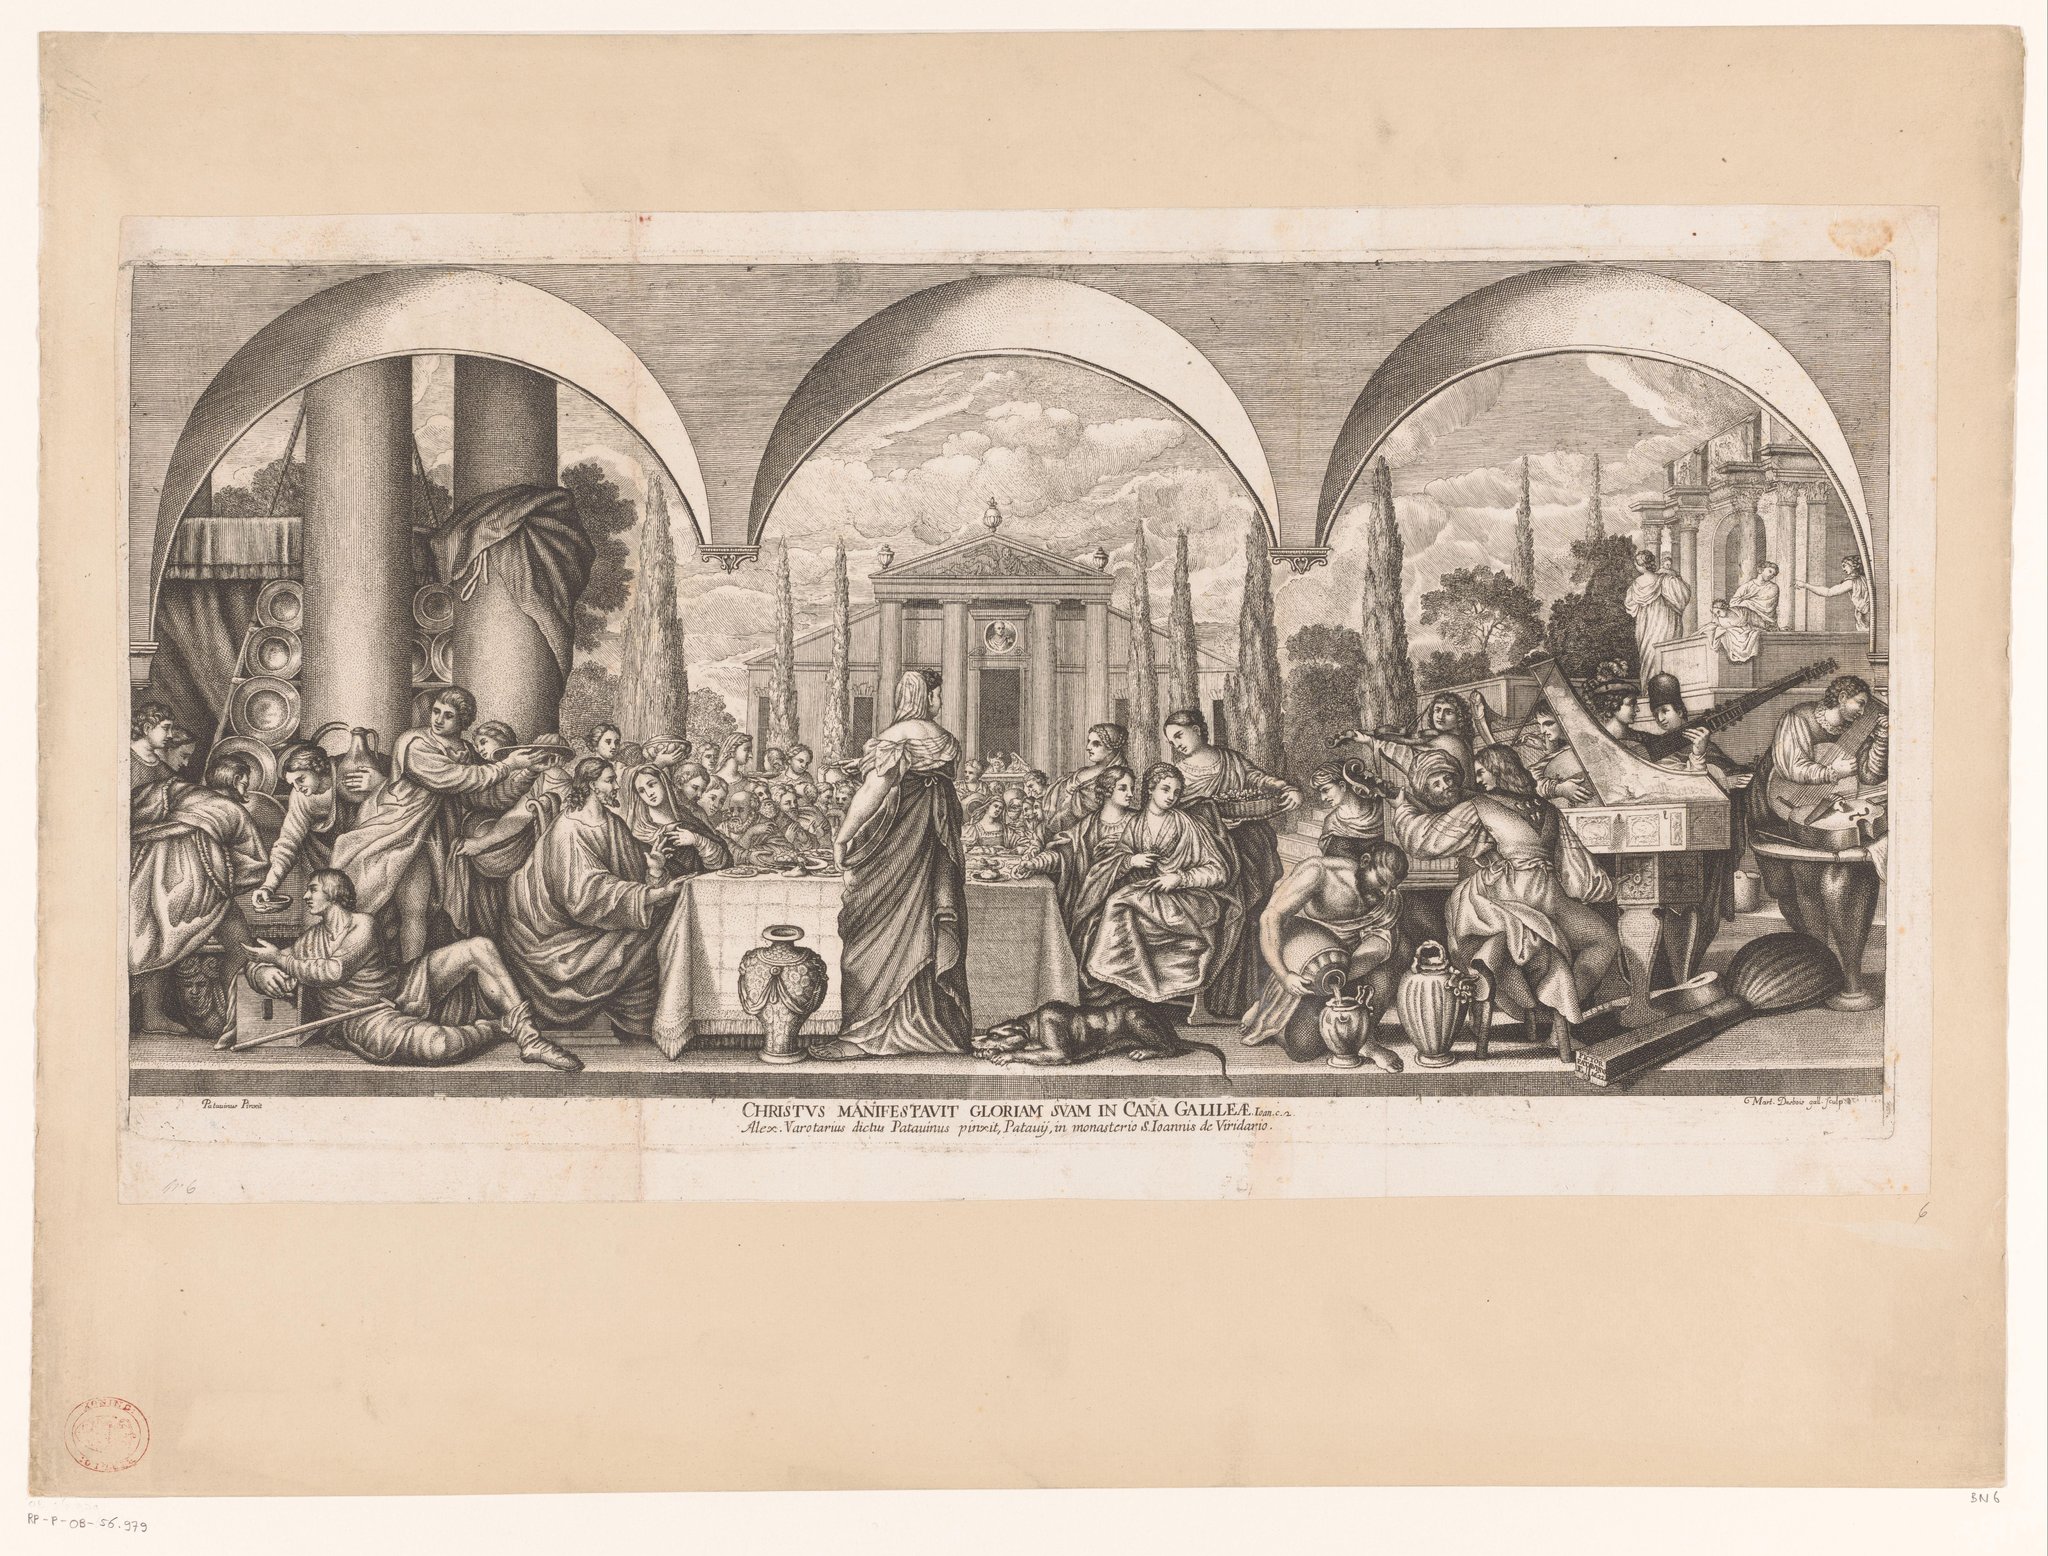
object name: book illustration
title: Christus Manifestavit Gloriam Suam in Cana Galileae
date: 1691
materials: paper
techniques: etching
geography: padua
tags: the marriage-feast at cana (john 2:1-11)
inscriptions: collector's mark: Lugt 240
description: Prent gebruikt voor: Patina, Carola Catharina. Tabellae selectae ac explicatae. Padua: Ex Typographia Seminarii, 1691.